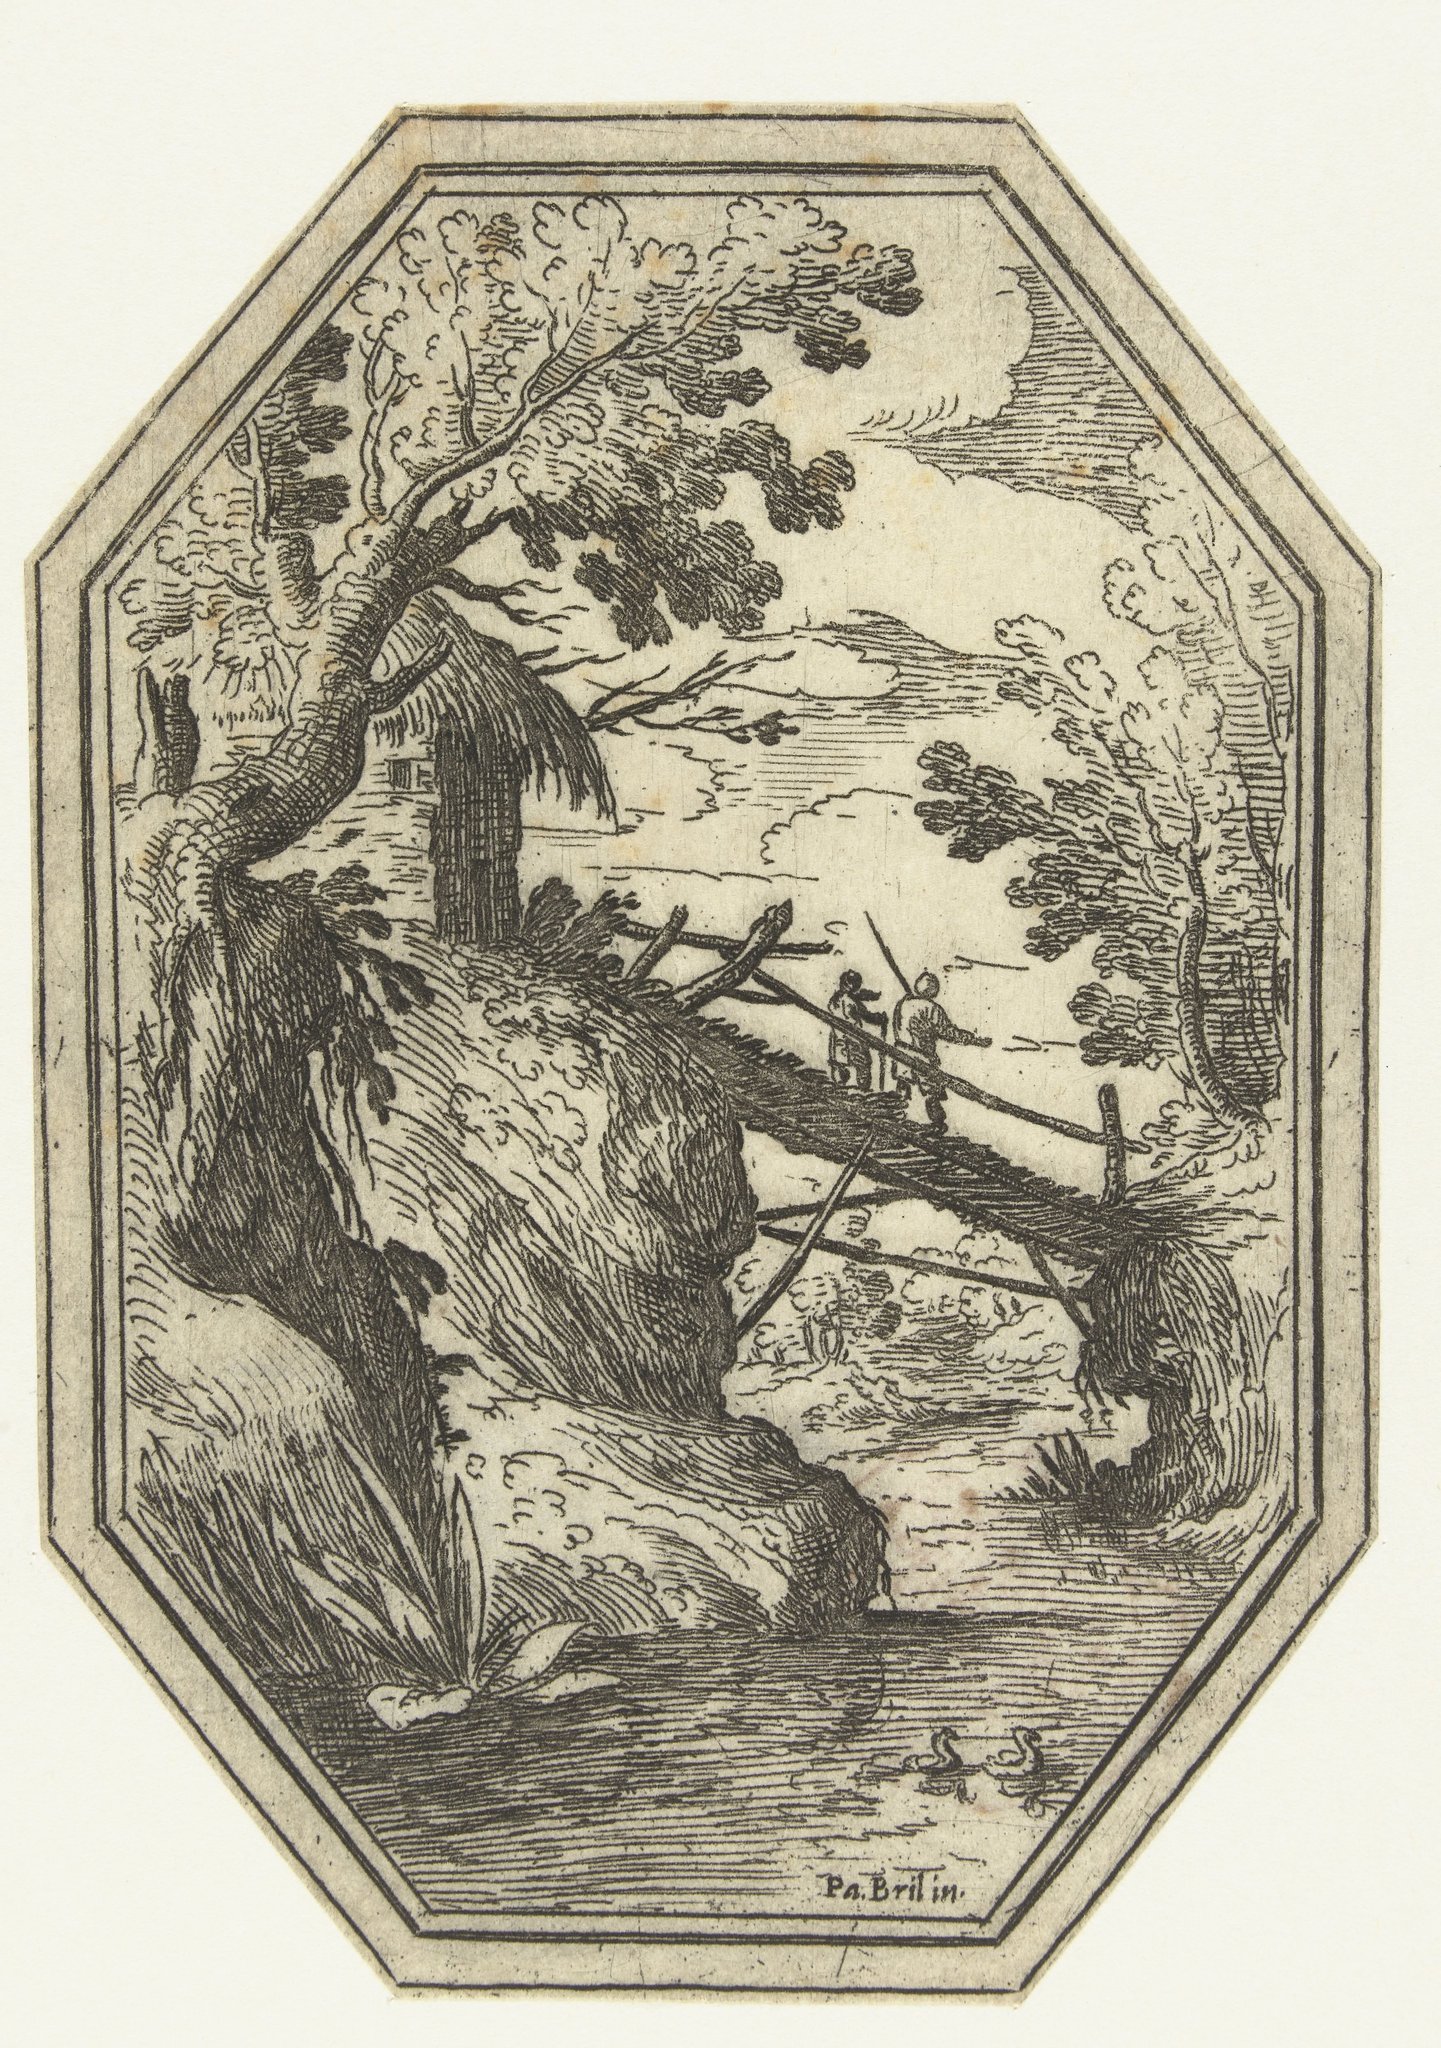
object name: print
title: Octagonale Landschappen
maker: paul bril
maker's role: draughtsman, print maker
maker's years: 1554-1626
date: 1582-1626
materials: paper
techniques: etching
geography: rome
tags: landscape with bridge, viaduct or aqueduct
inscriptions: collector's mark: Lugt 240